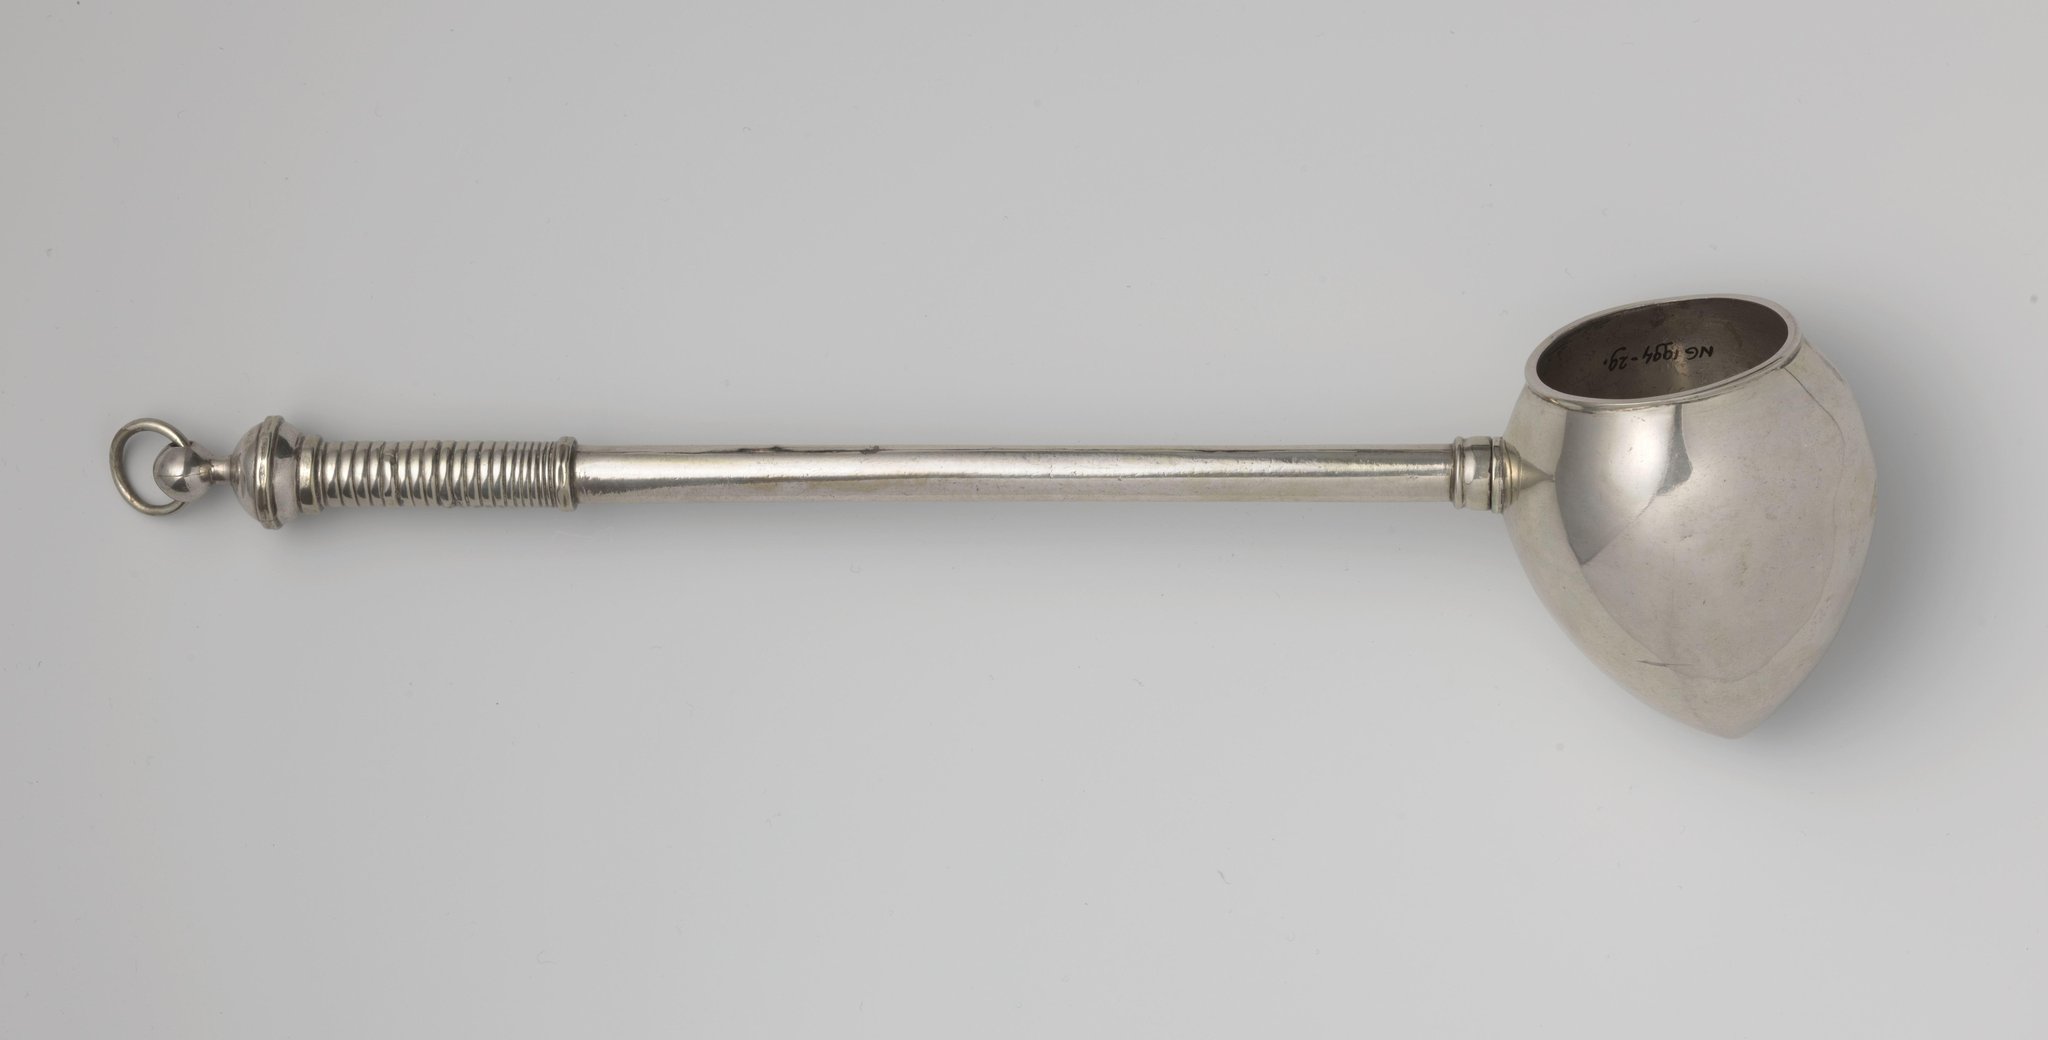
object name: waterschepper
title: Curaçaose waterschepper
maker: Anonymous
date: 1700-1799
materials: silver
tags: west-indische compagnie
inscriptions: duty mark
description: Waterschep met de kop in de vorm van een kokosnoot. Rechte steel die aan het uiteinde is omwikkeld met een koord van zilver. Door de knop op het uiteinde zit een ring. Op de knop staat een belastingmerk.